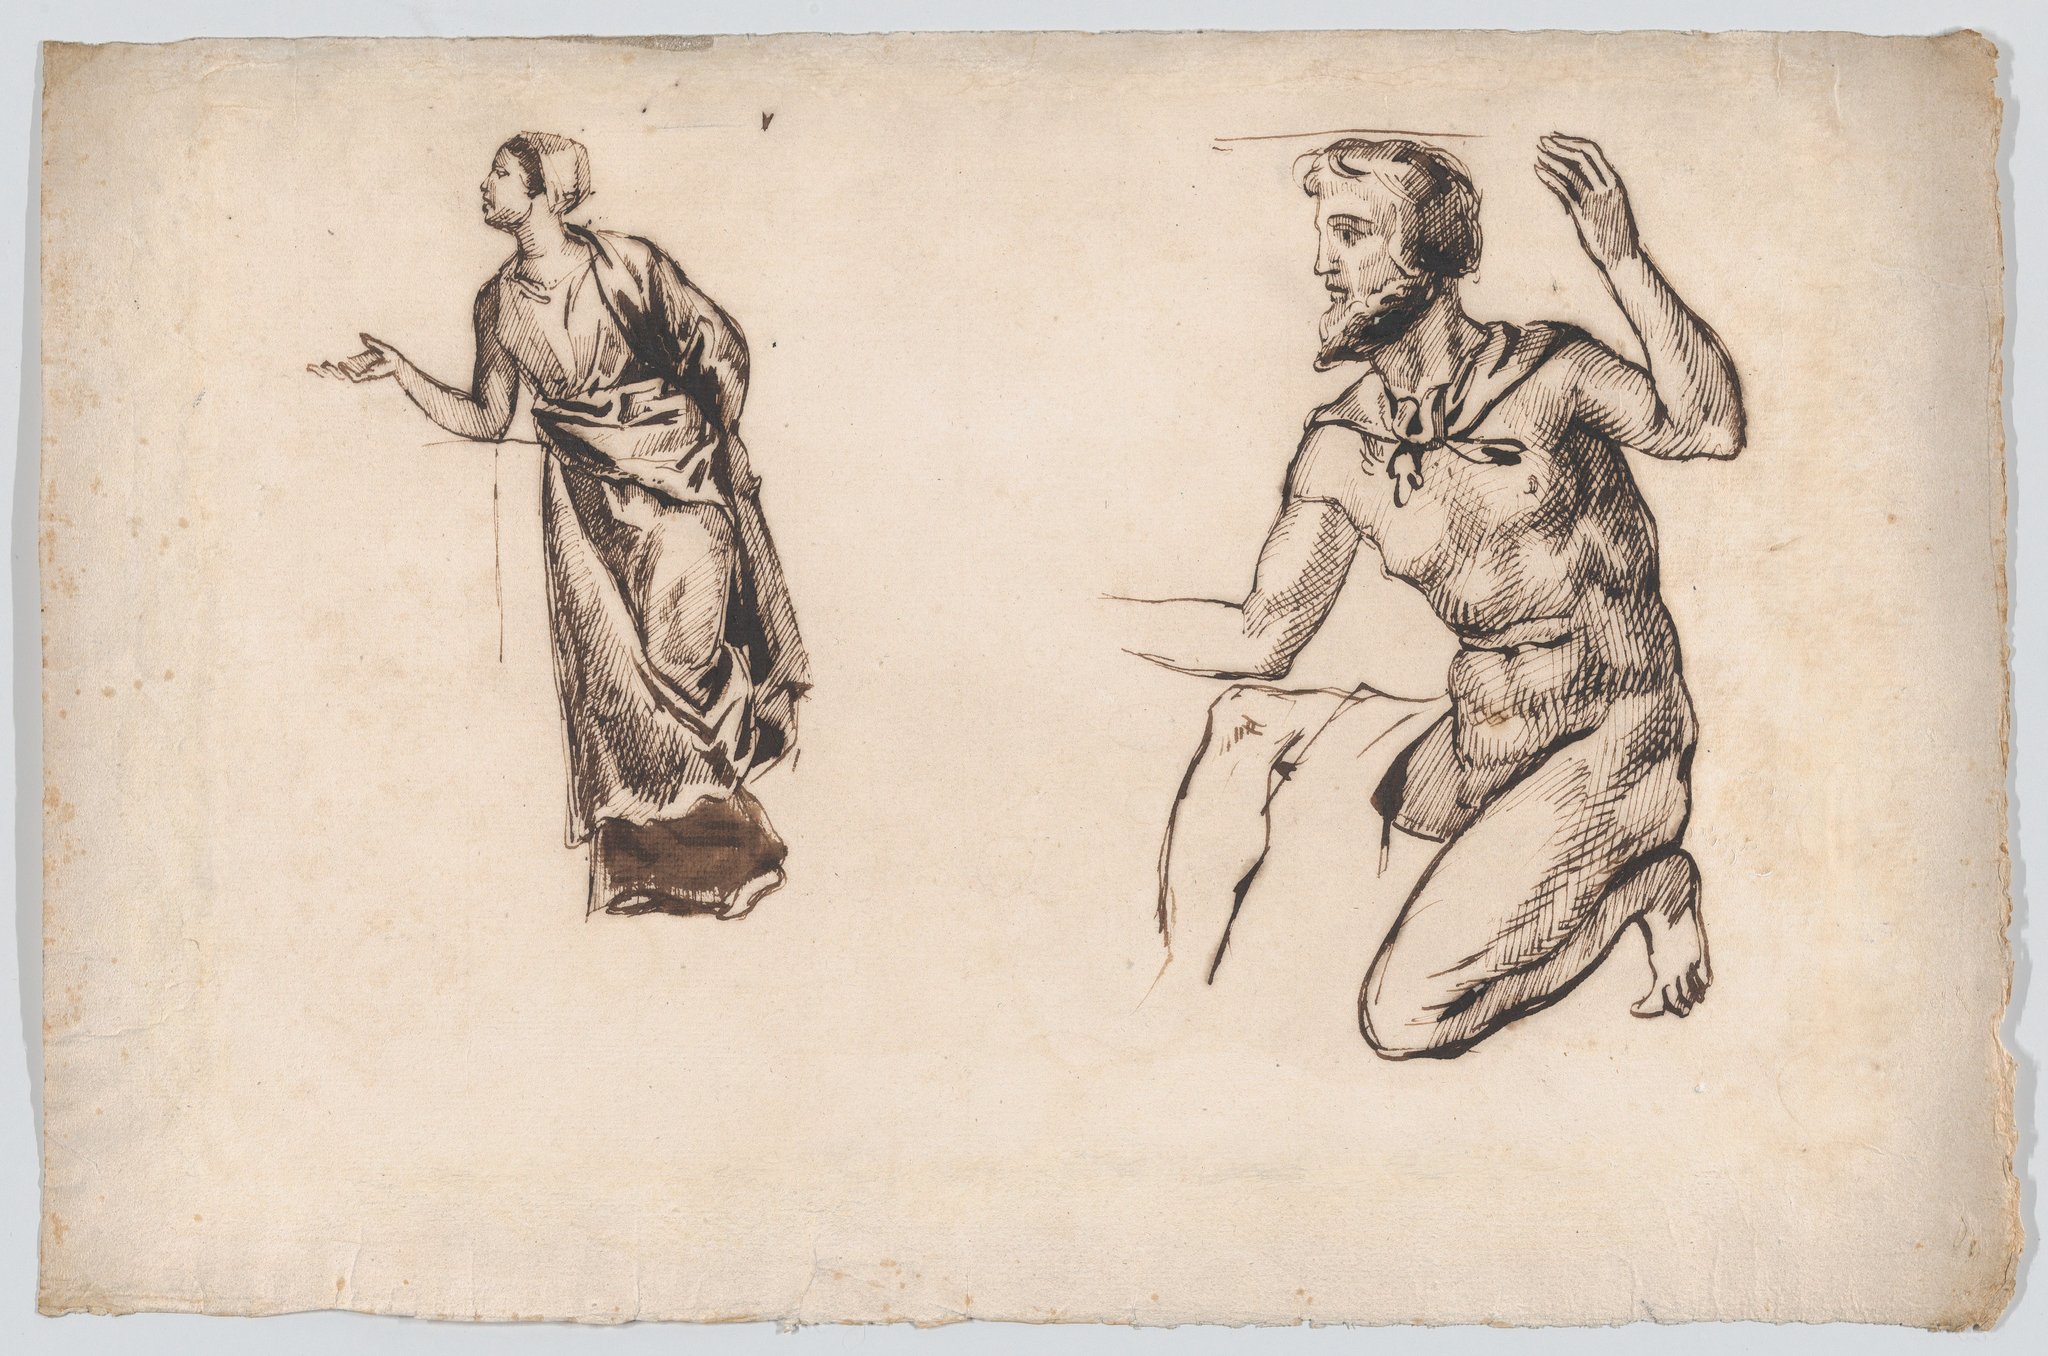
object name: drawing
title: Two Figure Studies: A Woman Standing and a Bearded Man Kneeling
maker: eugène delacroix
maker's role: artist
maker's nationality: french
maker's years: 1798-1863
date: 1820-1863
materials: ink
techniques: brush, pen, wash